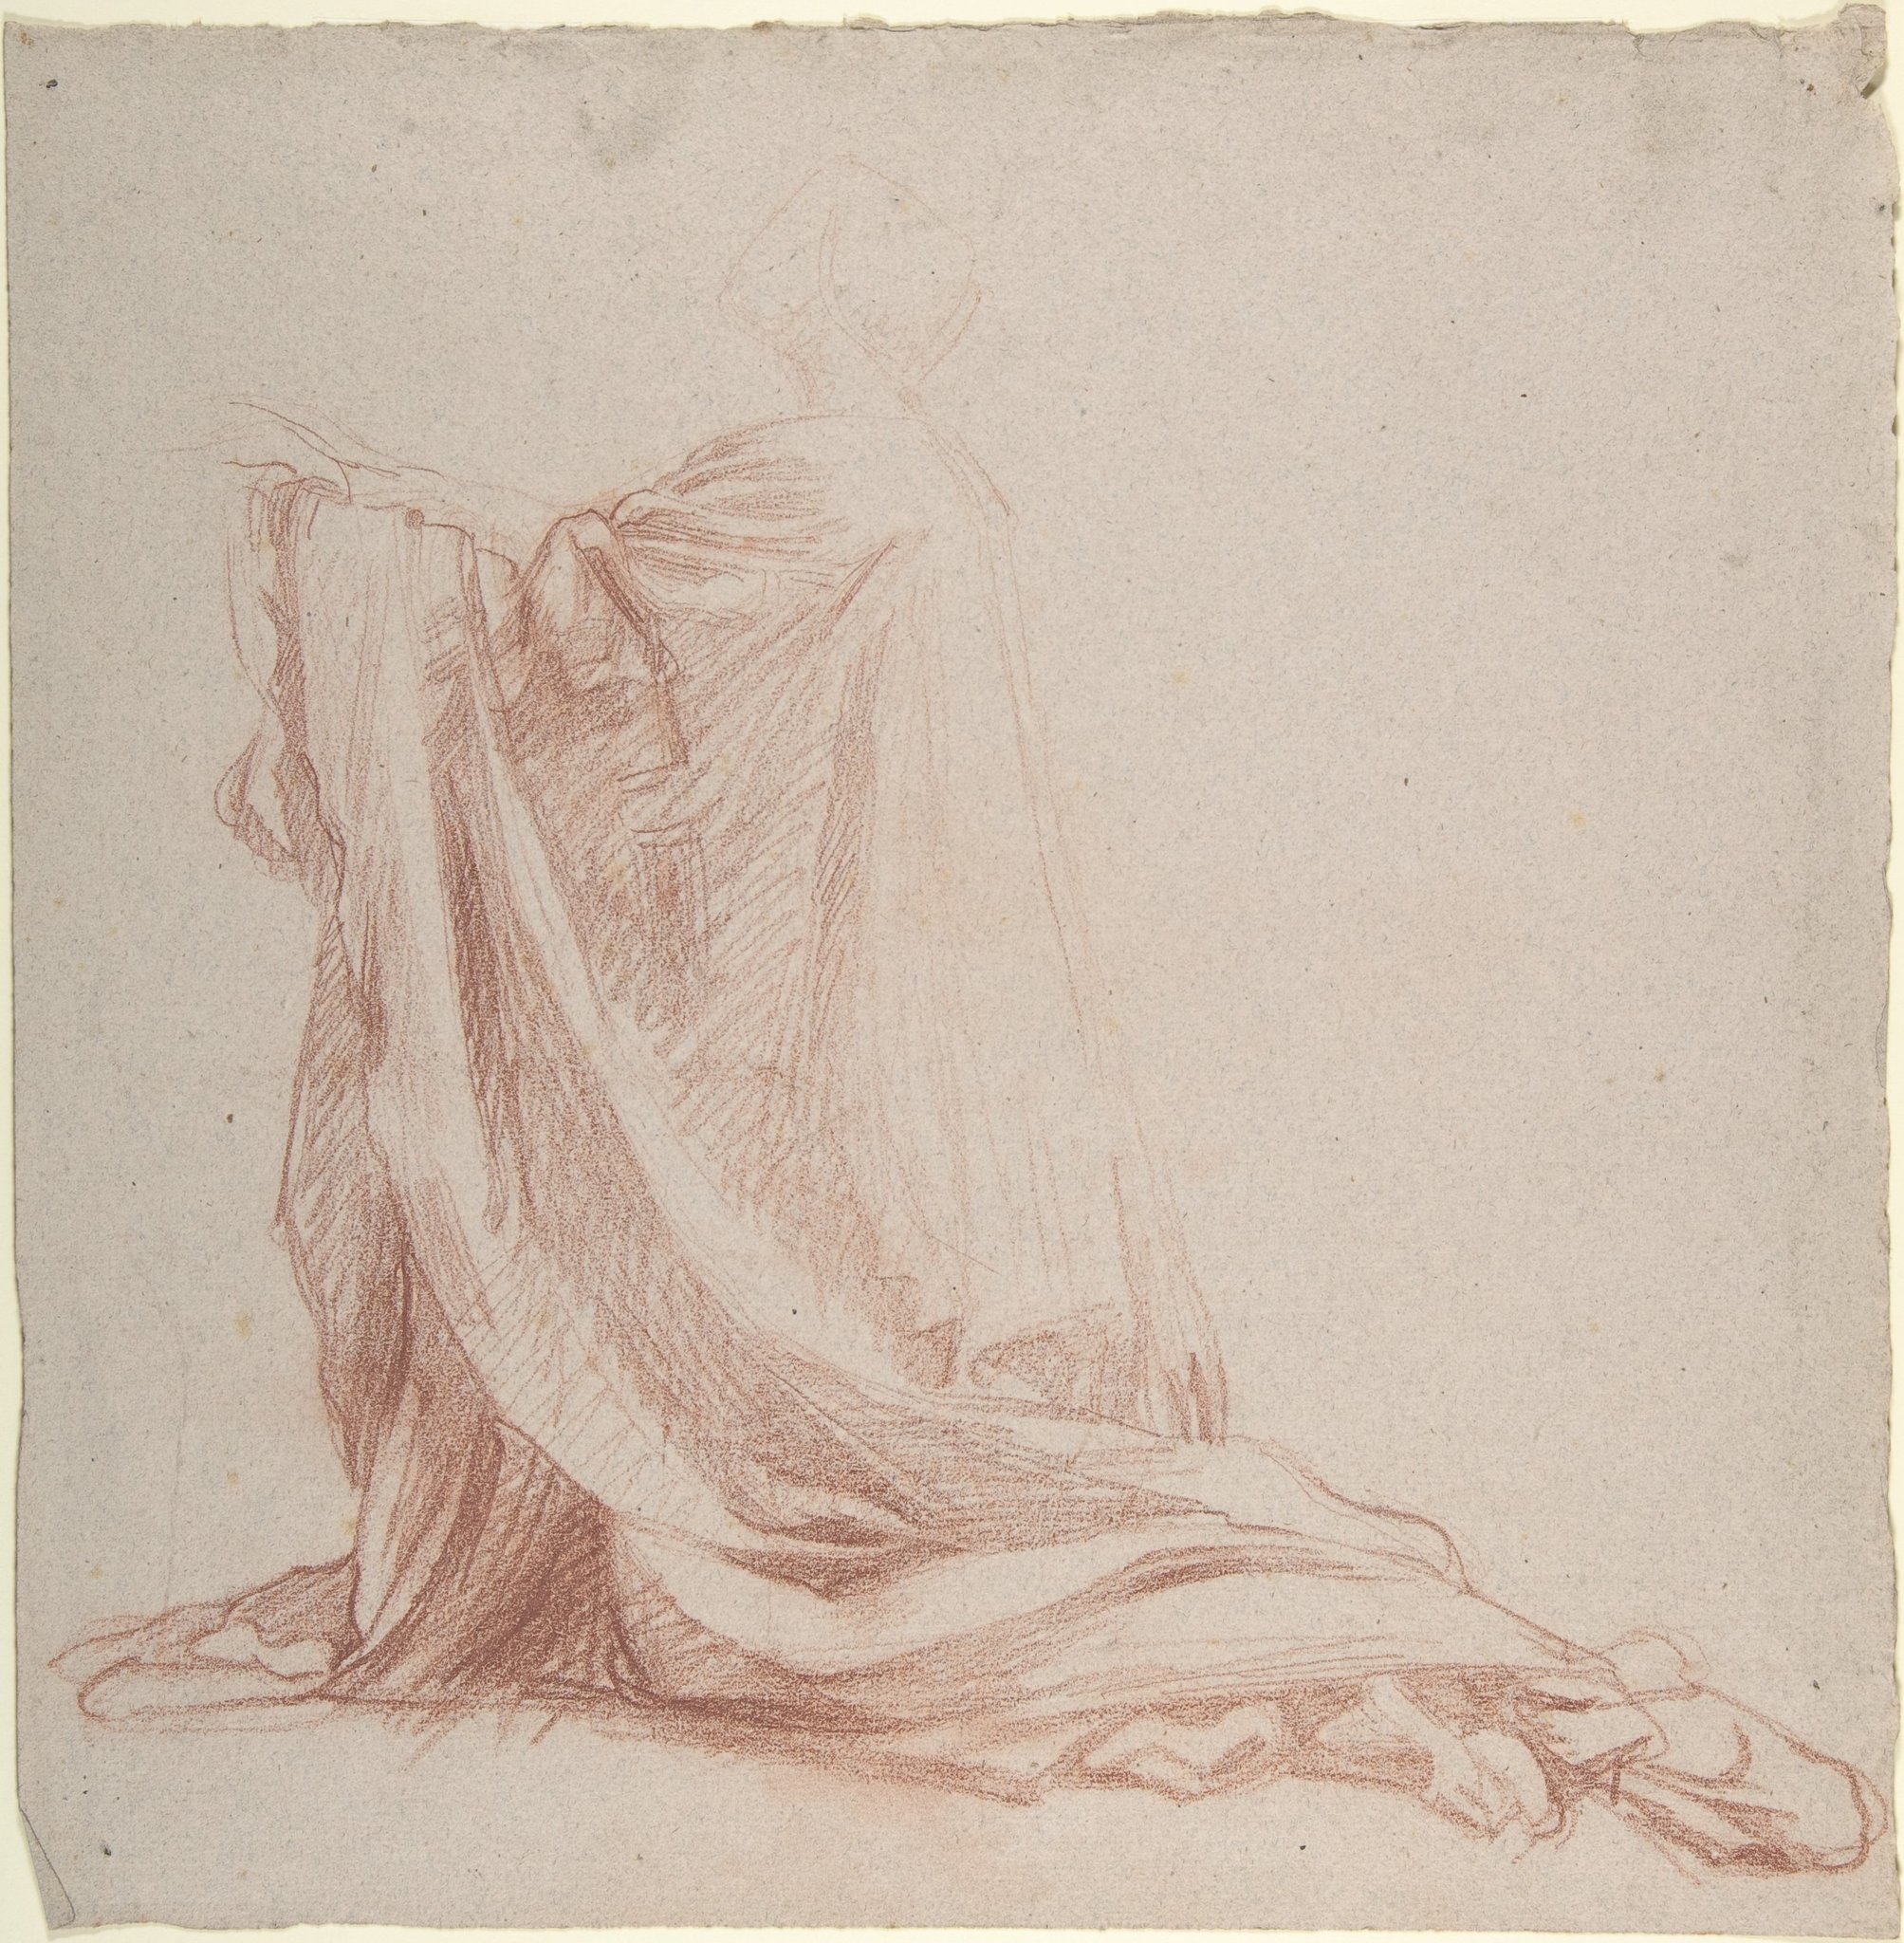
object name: drawing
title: Kneeling Prelate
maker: alexandre laemlein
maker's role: artist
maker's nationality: french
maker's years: 1813-1871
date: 1830-1871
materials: chalk, paper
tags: human figures